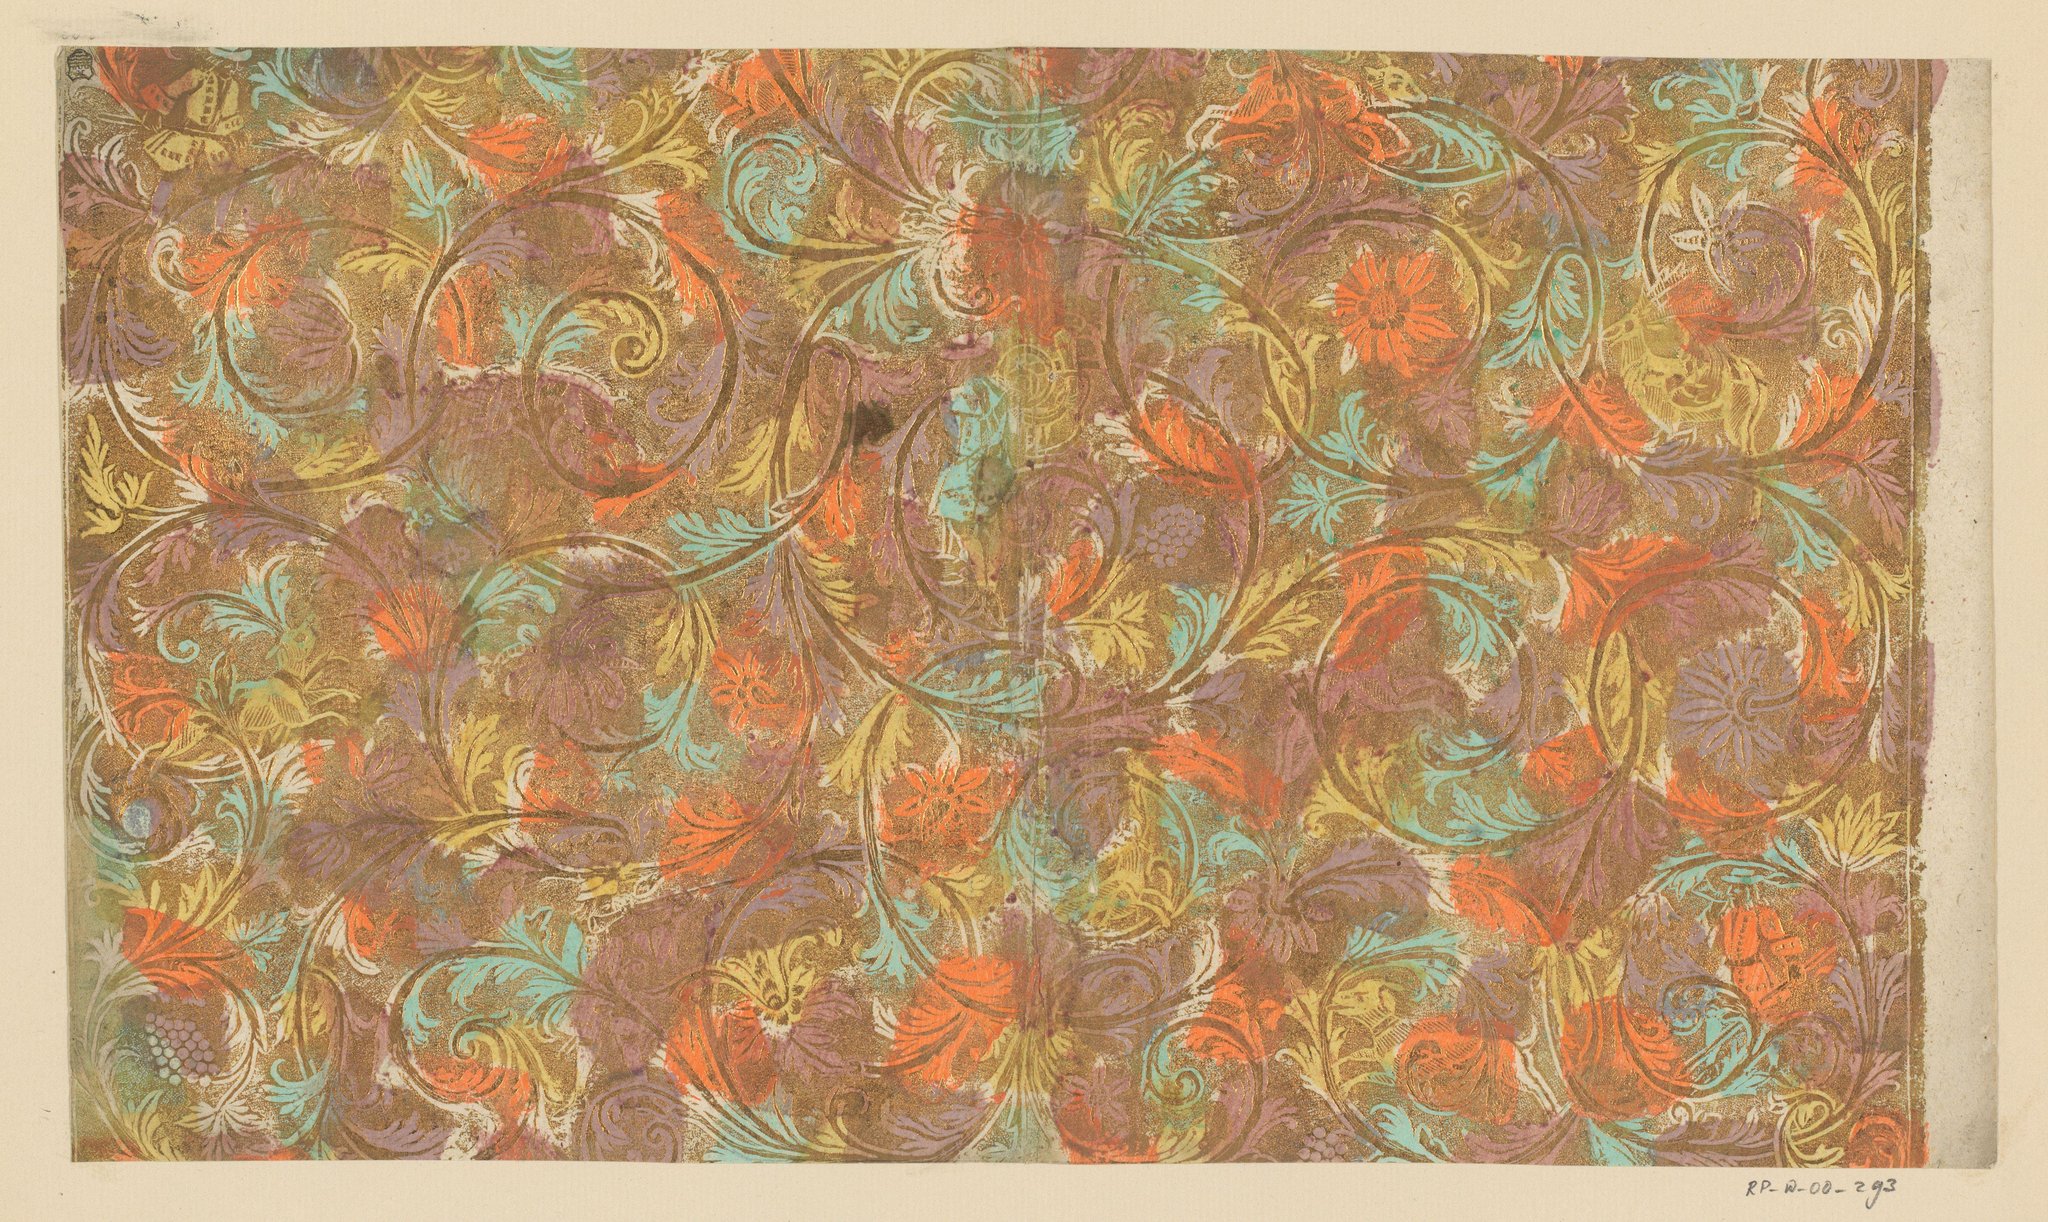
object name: brocade paper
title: Blad met ranken met bloemen en vruchten met jachtscènes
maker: johann michael munck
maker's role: ontwerper sierpapier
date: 1730-1760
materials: gold leaf, paint, paper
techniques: relief print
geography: augsburg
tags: hunting, chase, ornament derived from plant forms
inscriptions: collector's mark: Lugt 2760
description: Blad met ranken uitlopend in een krul met bloemen en vruchten met jachtscènes (jager blazend op jachthoorn, jachthond en hert). Gebruikt als omslag.